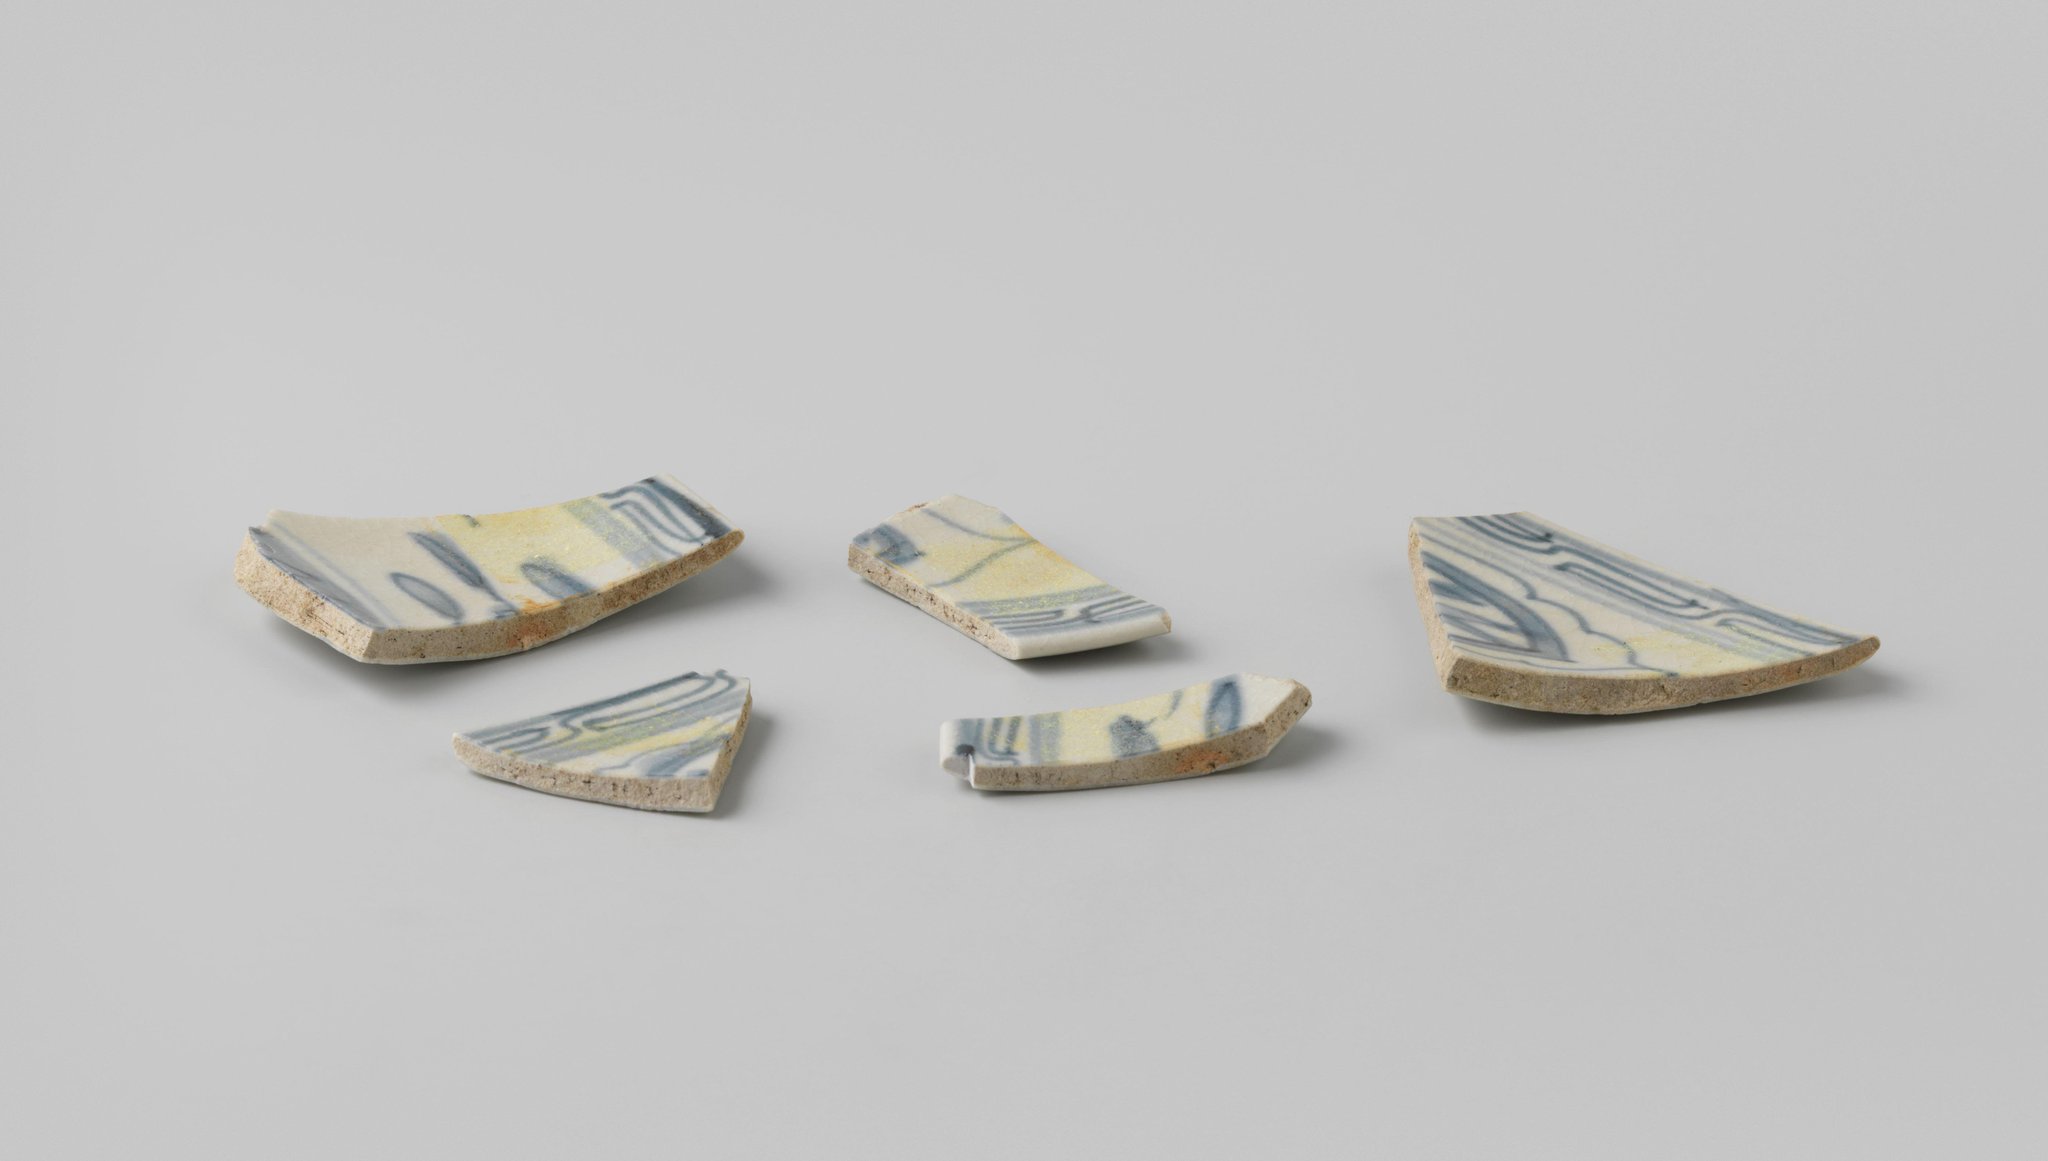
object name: sherd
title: Scherven van een bord uit V.O.C.-schip de 'Witte Leeuw'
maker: Anonymous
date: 1613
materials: porcelain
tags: verenigde oostindische compagnie, sint-helena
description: Scherven van een bord uit V.O.C.-schip de 'Witte Leeuw'.